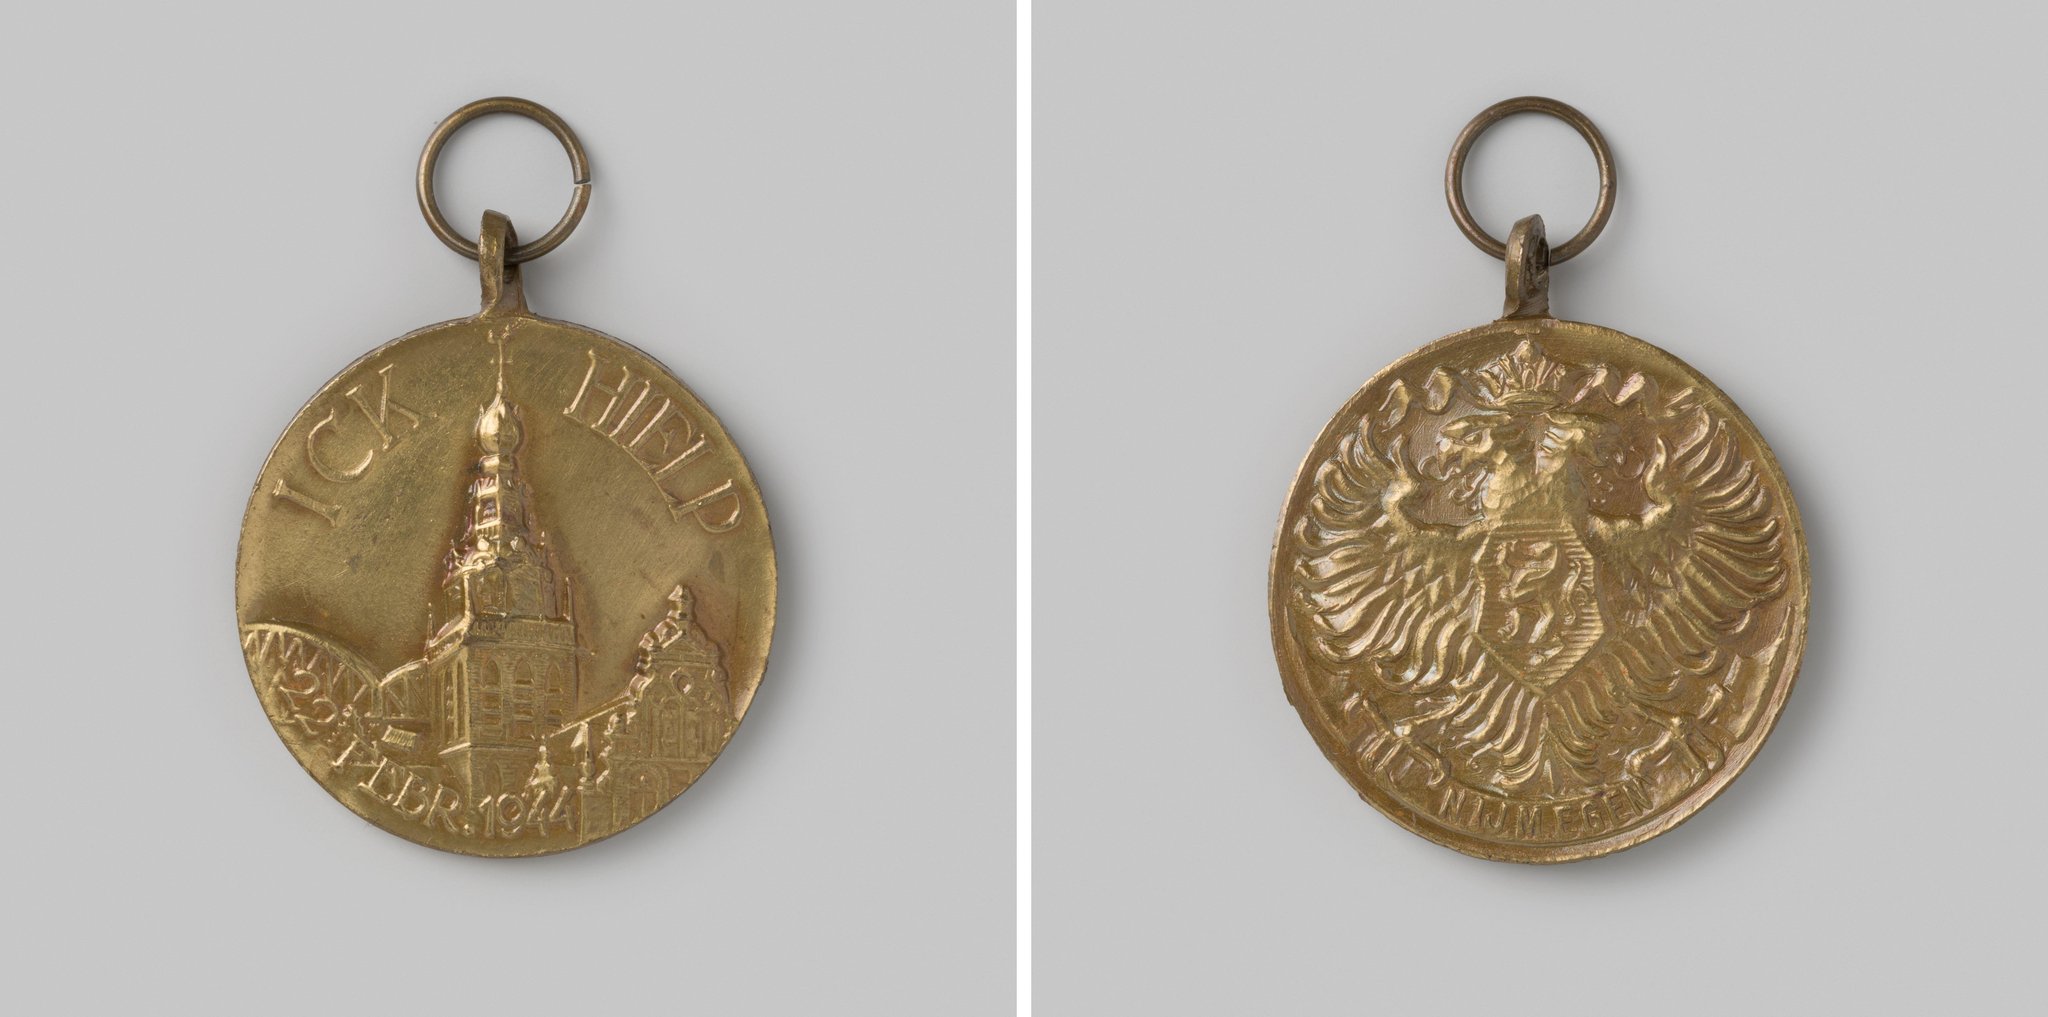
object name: history medal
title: Hulpverlening bij het bombardement van Nijmegen 1944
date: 1944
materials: brass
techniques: striking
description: Messing penning met bal en draagoog, op de voorzijde drie Nijmeegse bouwwerken met omschrift, op de keerzijde een gekroonde dubbelkoppige adelaar met hartschild leeuw en banderol in de klauwen.